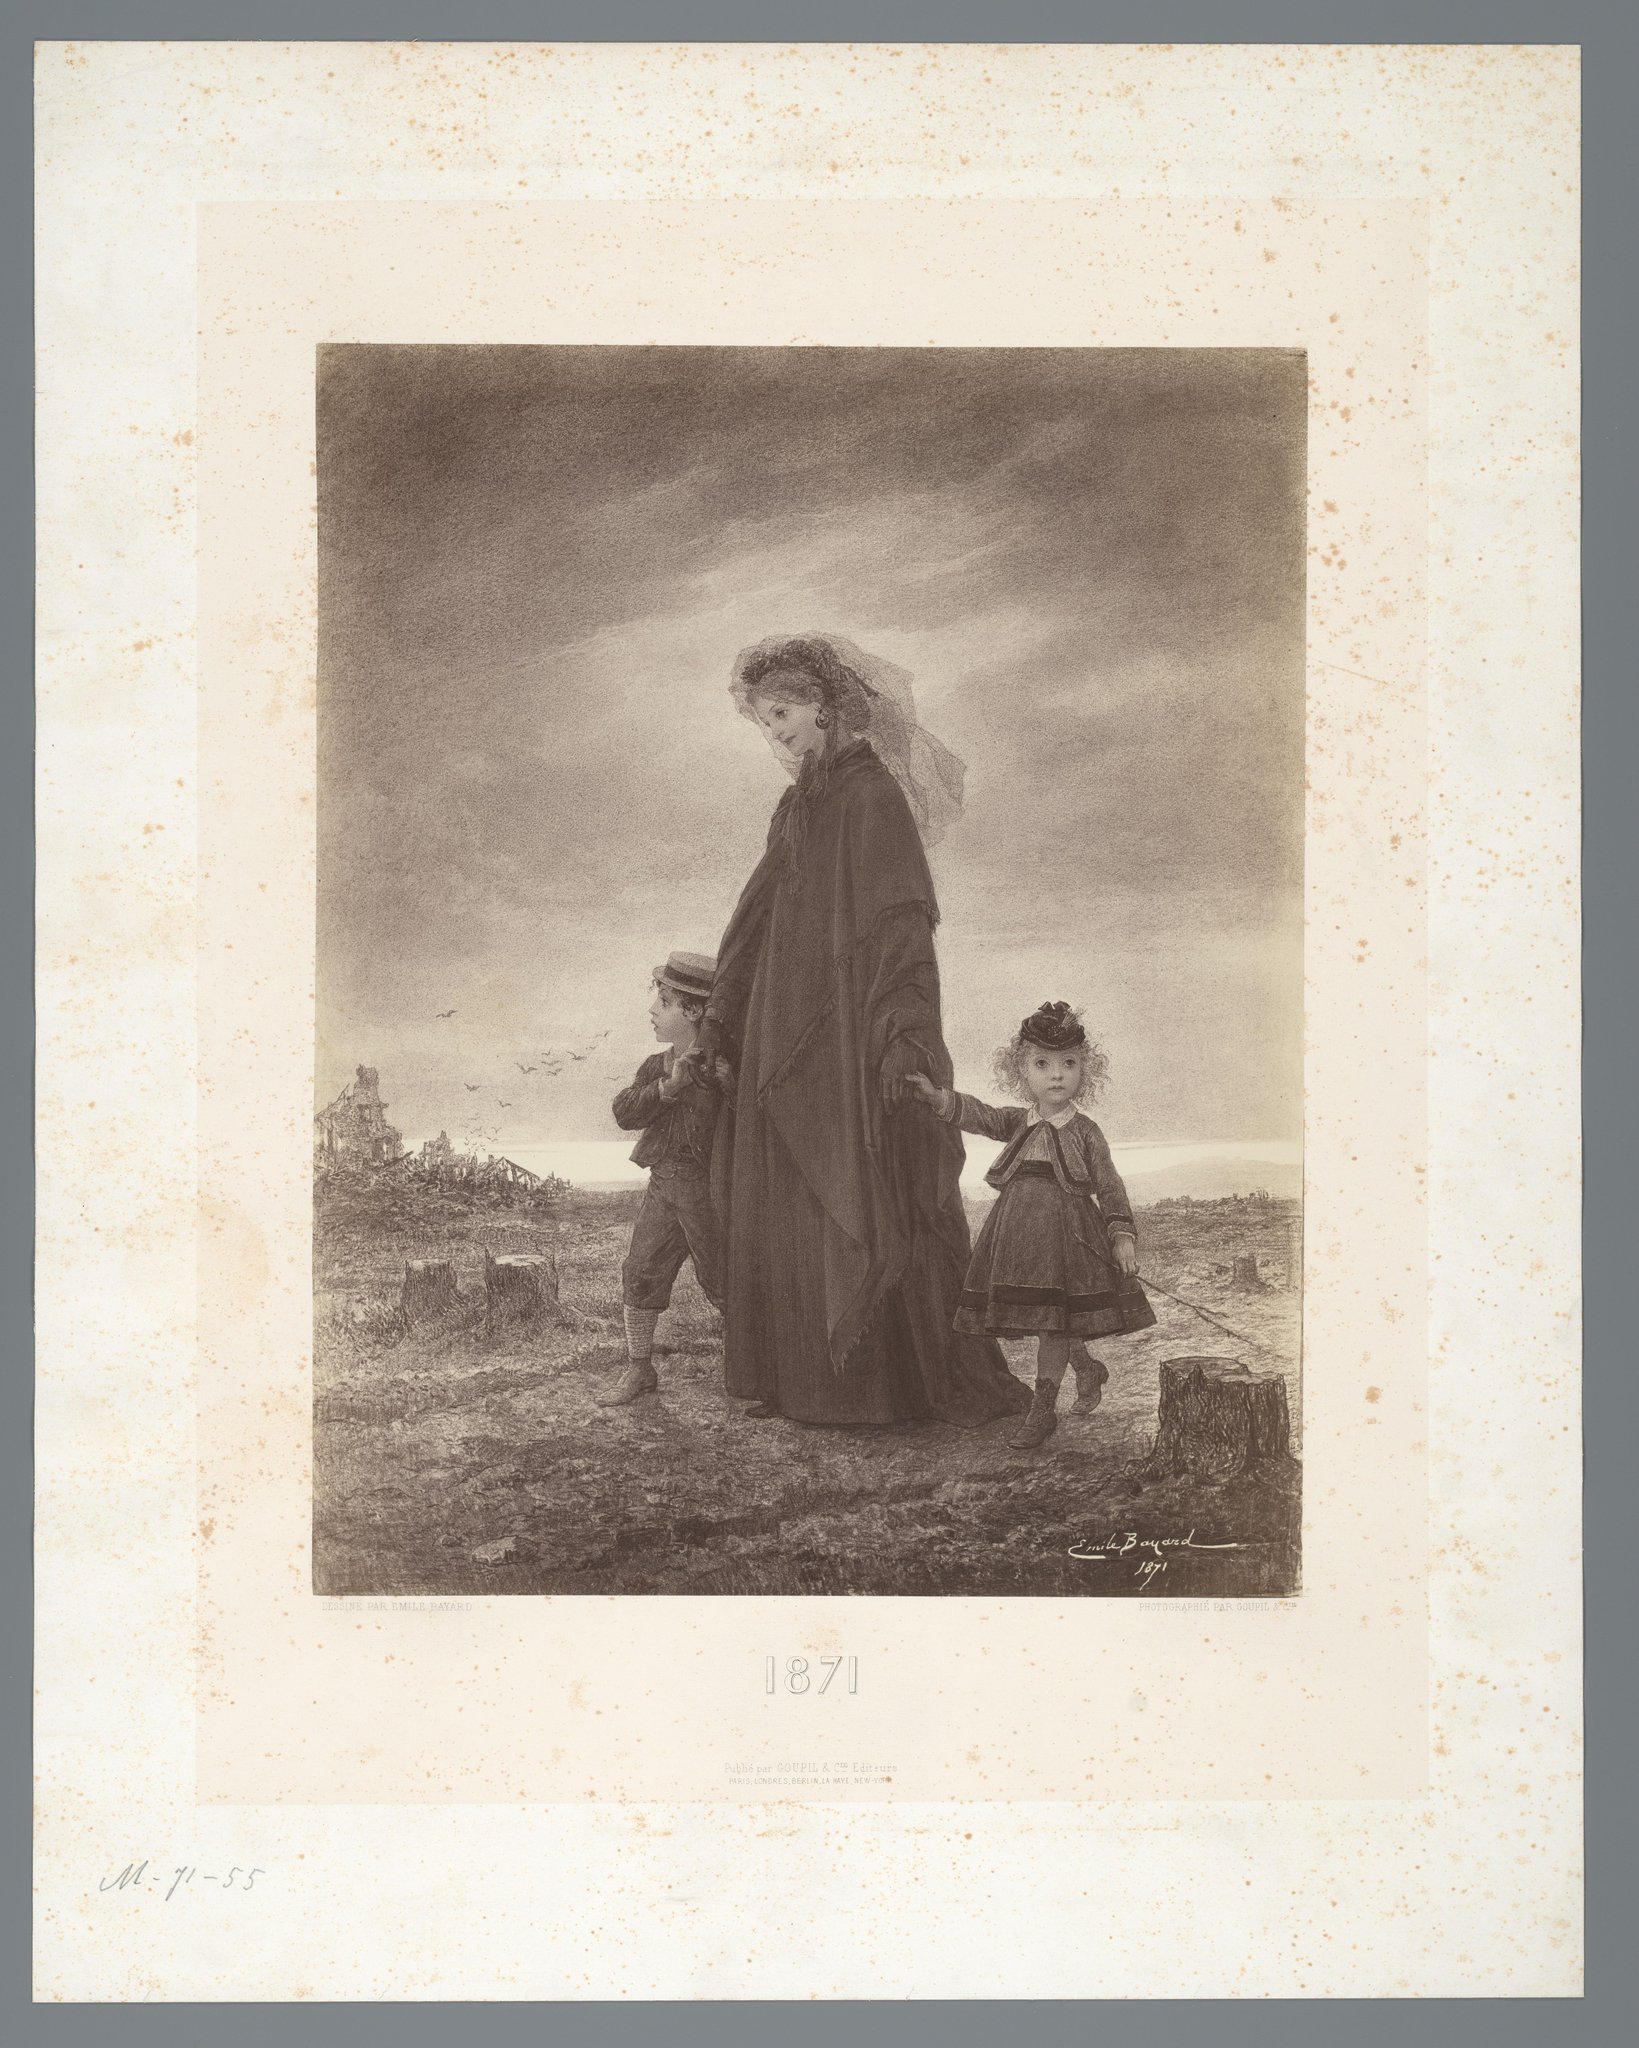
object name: reproduction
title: Fotoreproductie van een tekening van een weduwe met kinderen in een oorlogslandschap door Émile-Antoine Bayard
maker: émile-antoine bayard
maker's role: draughtsman, painter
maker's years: 1837-1891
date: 1871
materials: cardboard, paper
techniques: albumen print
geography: paris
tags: widow, mother and child(ren), woman and child(ren) (family group)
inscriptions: inscription: ‘M-71-55’, date: ‘1871’